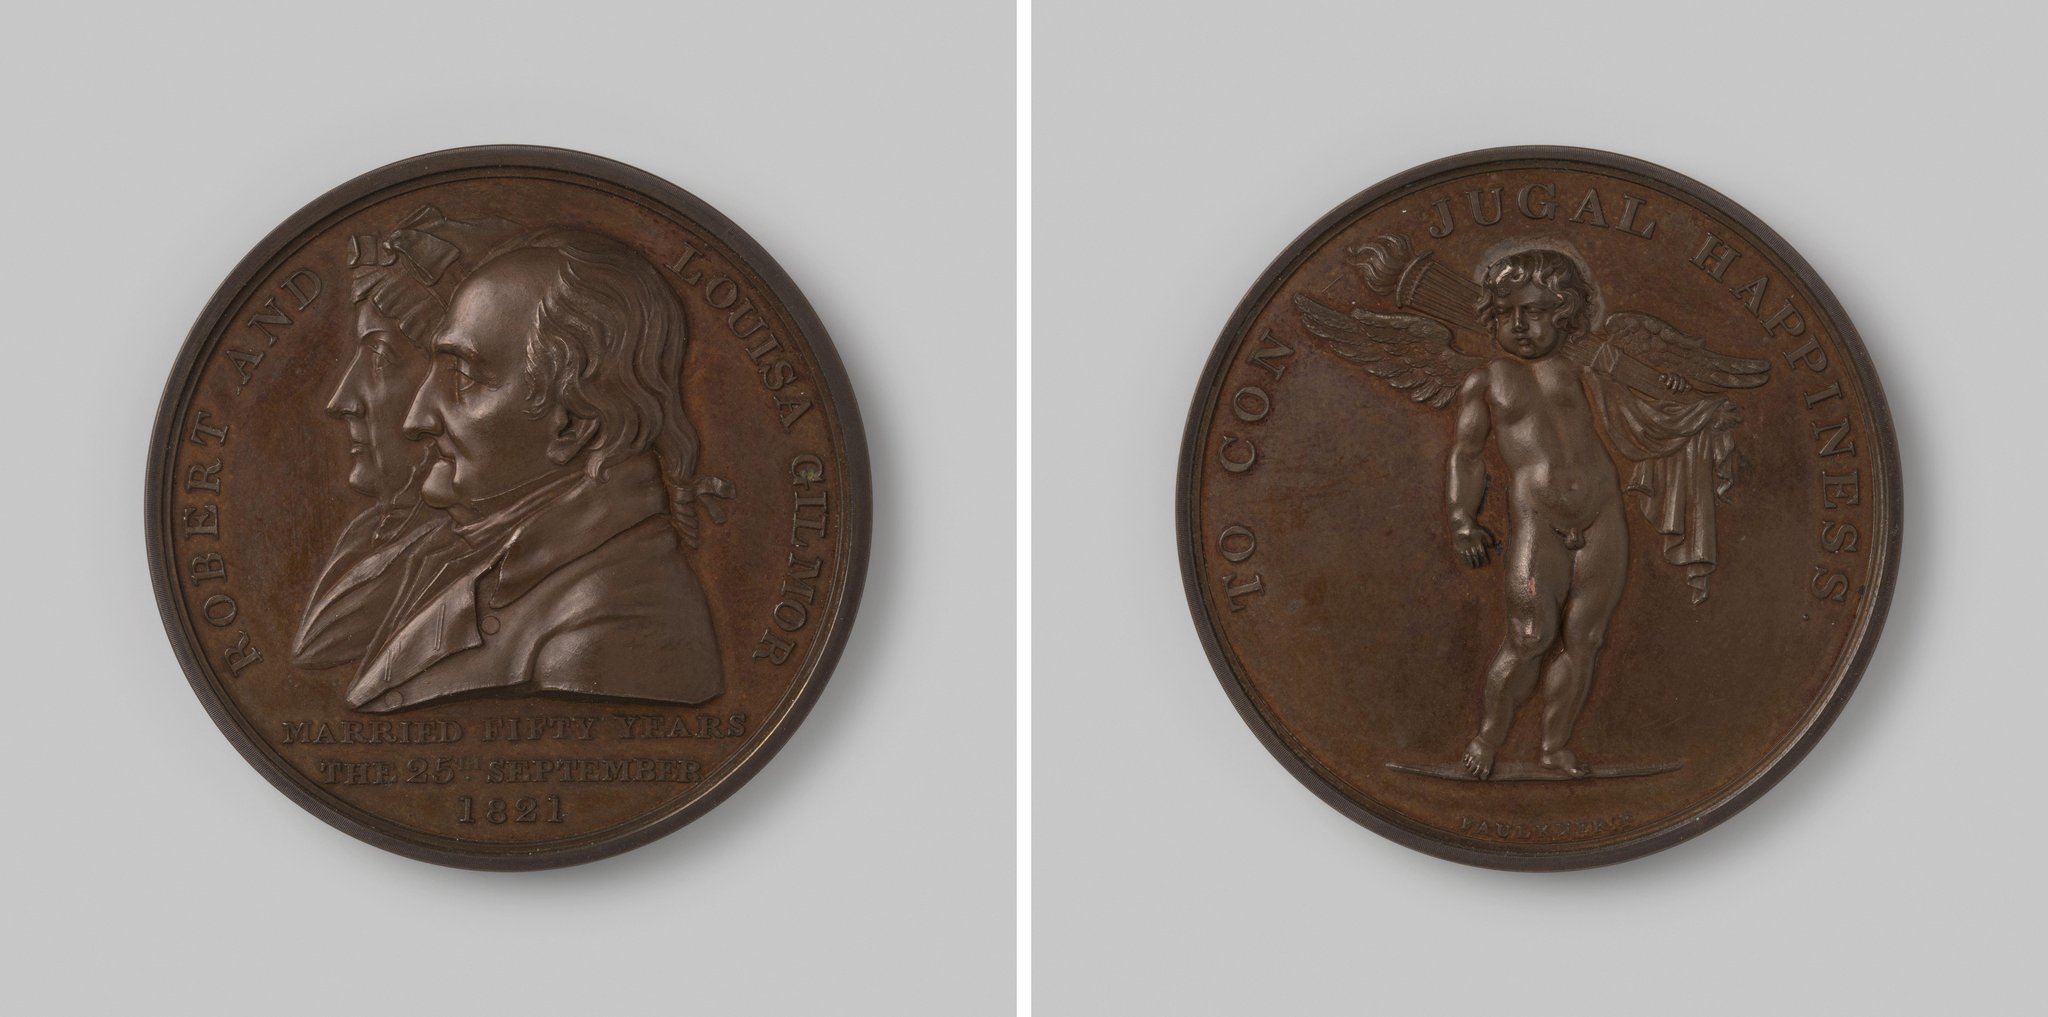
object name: history medal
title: Vijftigjarig huwelijk van Robert en Louisa Gilmore 1821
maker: f. faulkner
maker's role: die cutter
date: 1821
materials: copper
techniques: striking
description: Koperen penning, op de voorzijde de geconjugeerde borstbeelden van het echtpaar naar links met omschrift, op de keerzijde een staande jonge genius met toorts over de schouder, met omschrift.